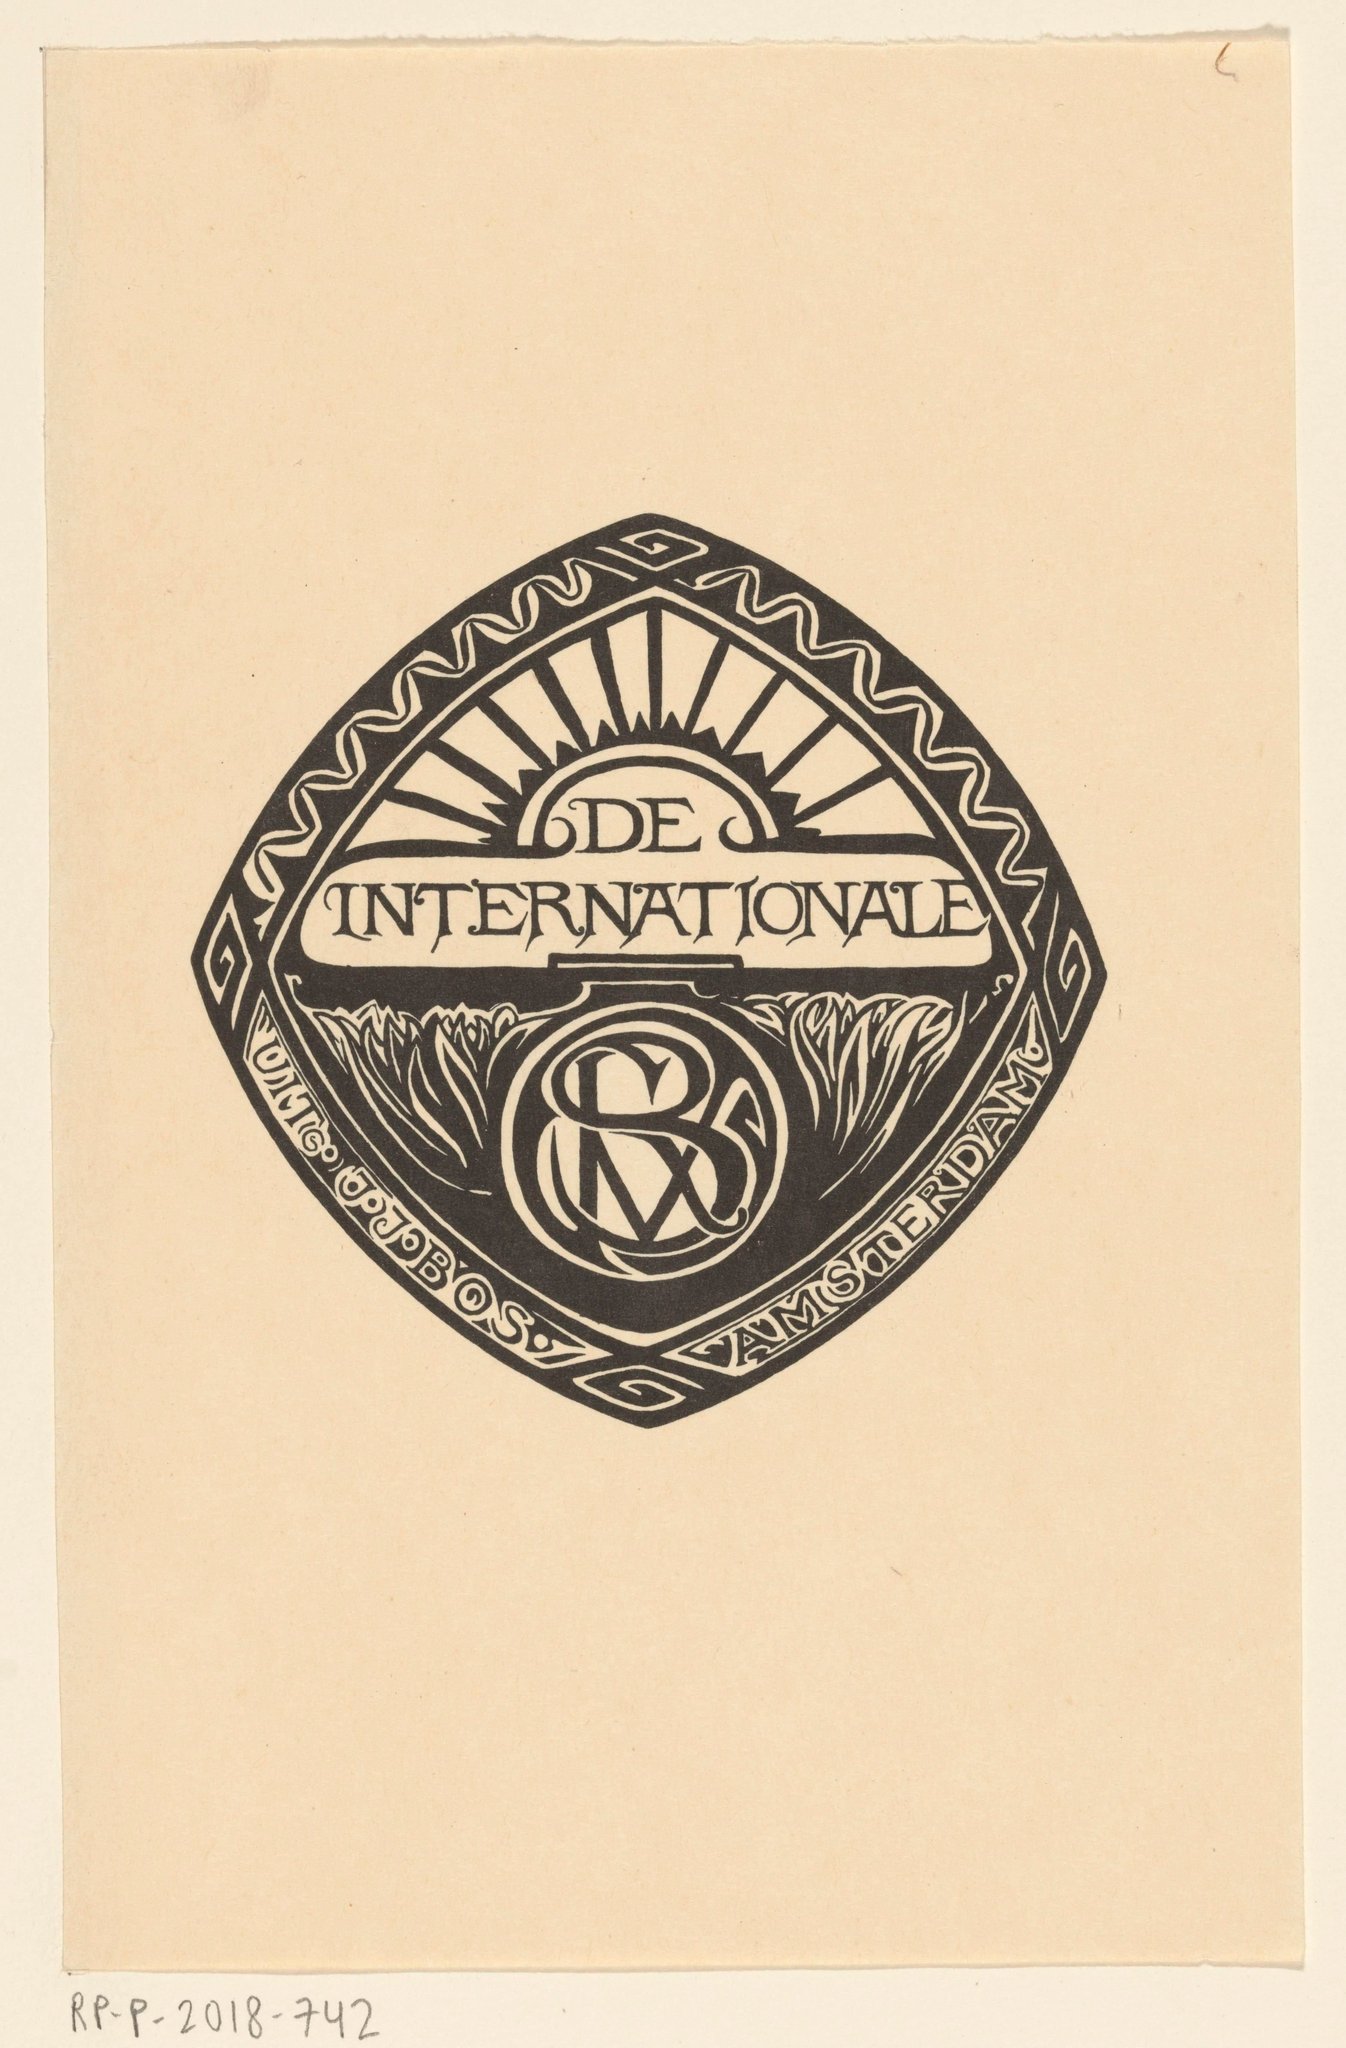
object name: print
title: De Internationale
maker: richard nicolaüs roland holst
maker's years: 1868-1938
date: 1911-1938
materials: paper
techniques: line block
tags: sun as celestial body, letter combinations such as letterword, anagram, letter square, monogram, etc.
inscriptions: number: ‘46’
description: Ontwerp voor: De Internationale, Orgaan van het Revolutionair-Socialistisch Verbond.